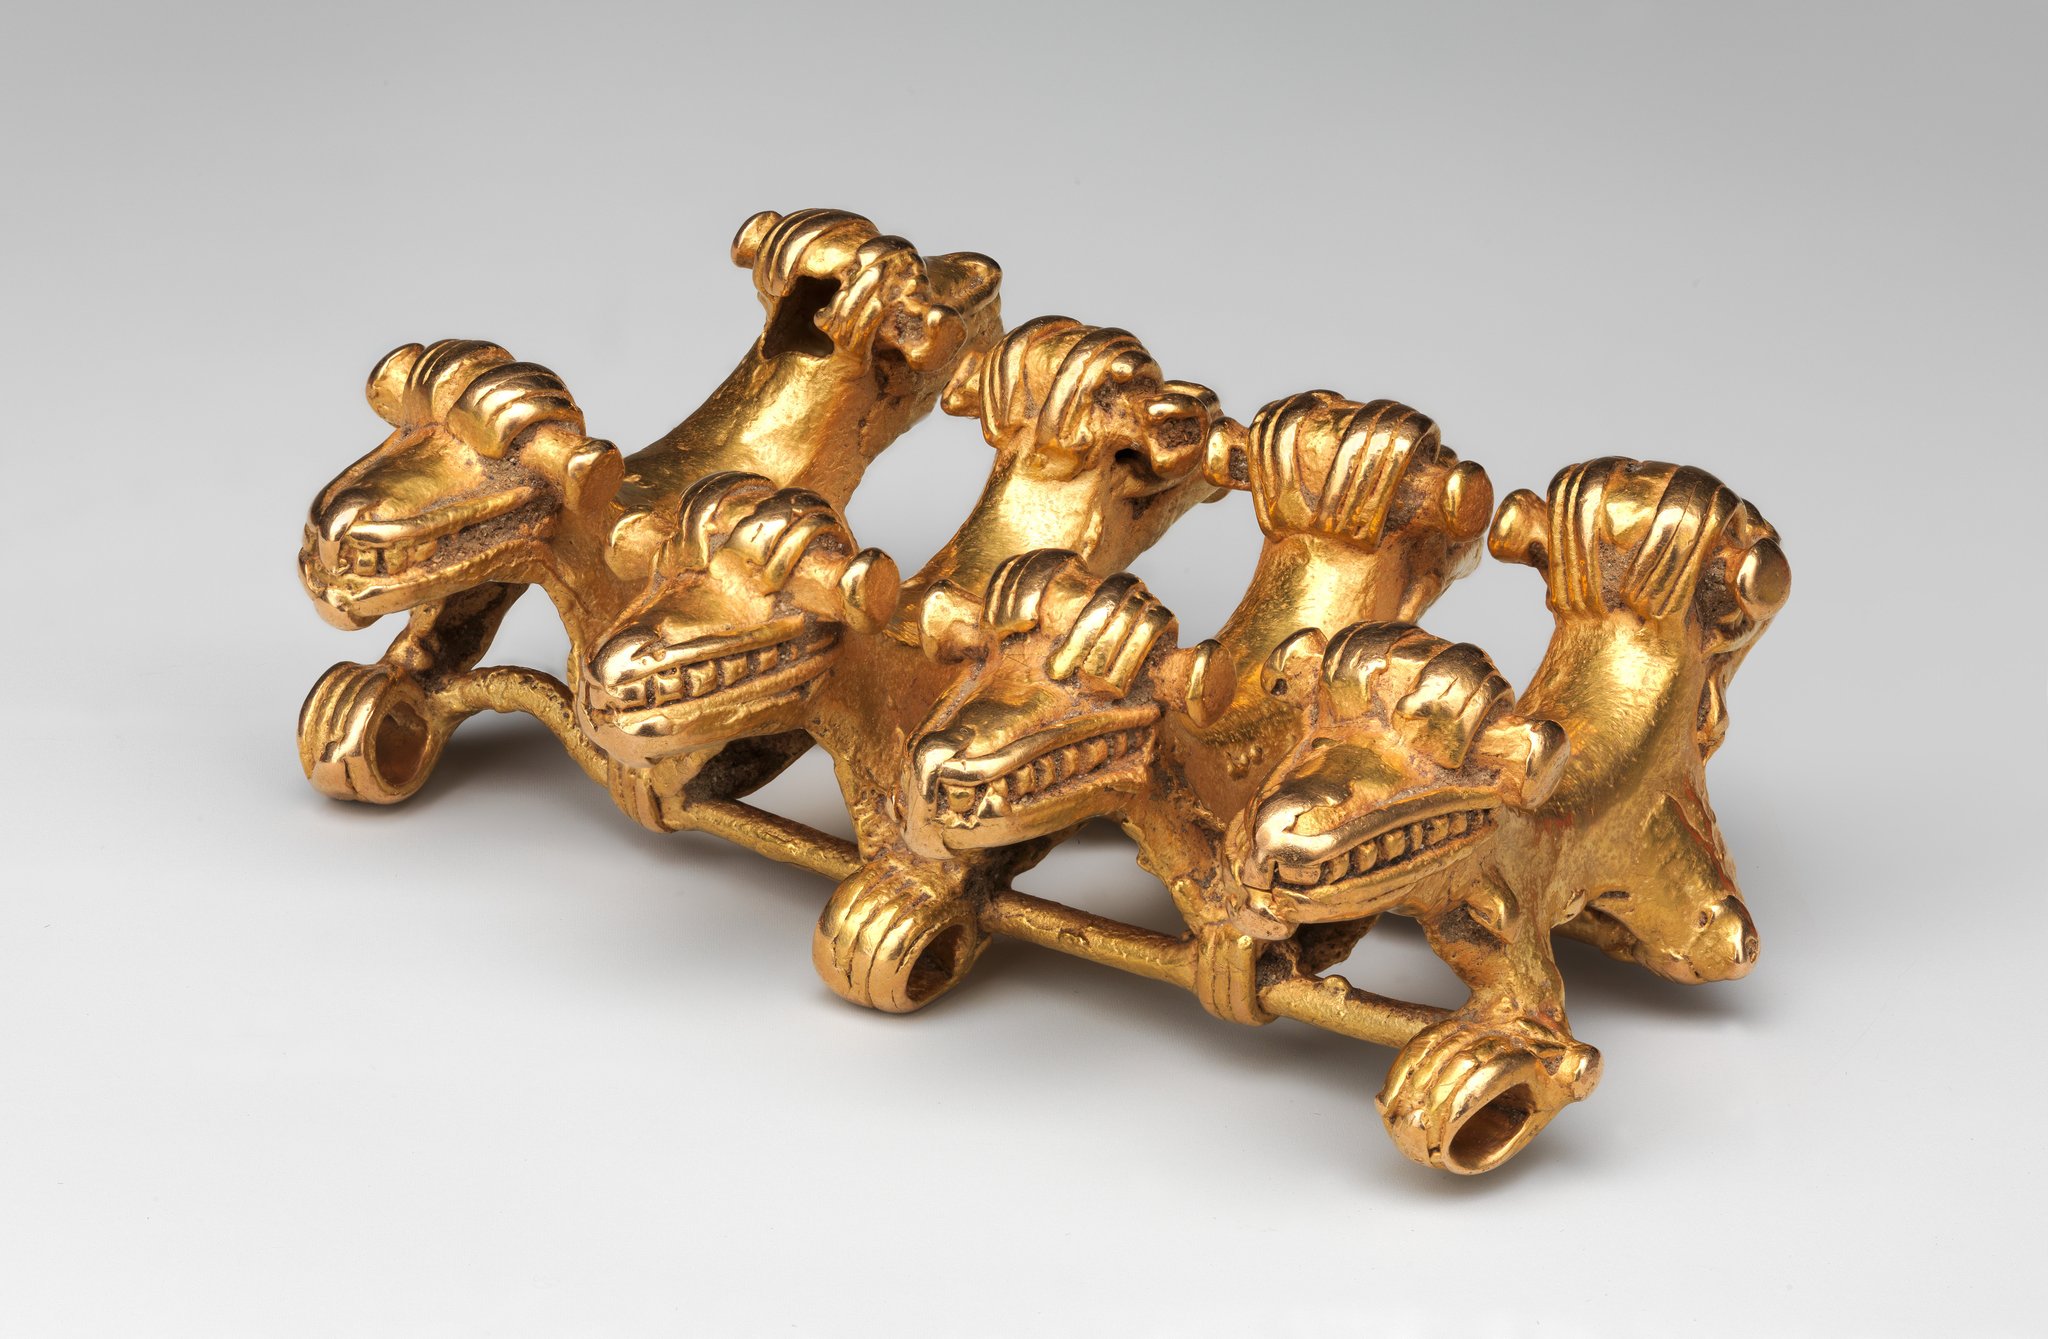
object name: pendant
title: Double-End Animal Pendant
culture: conte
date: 401-800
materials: gold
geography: panama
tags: animals